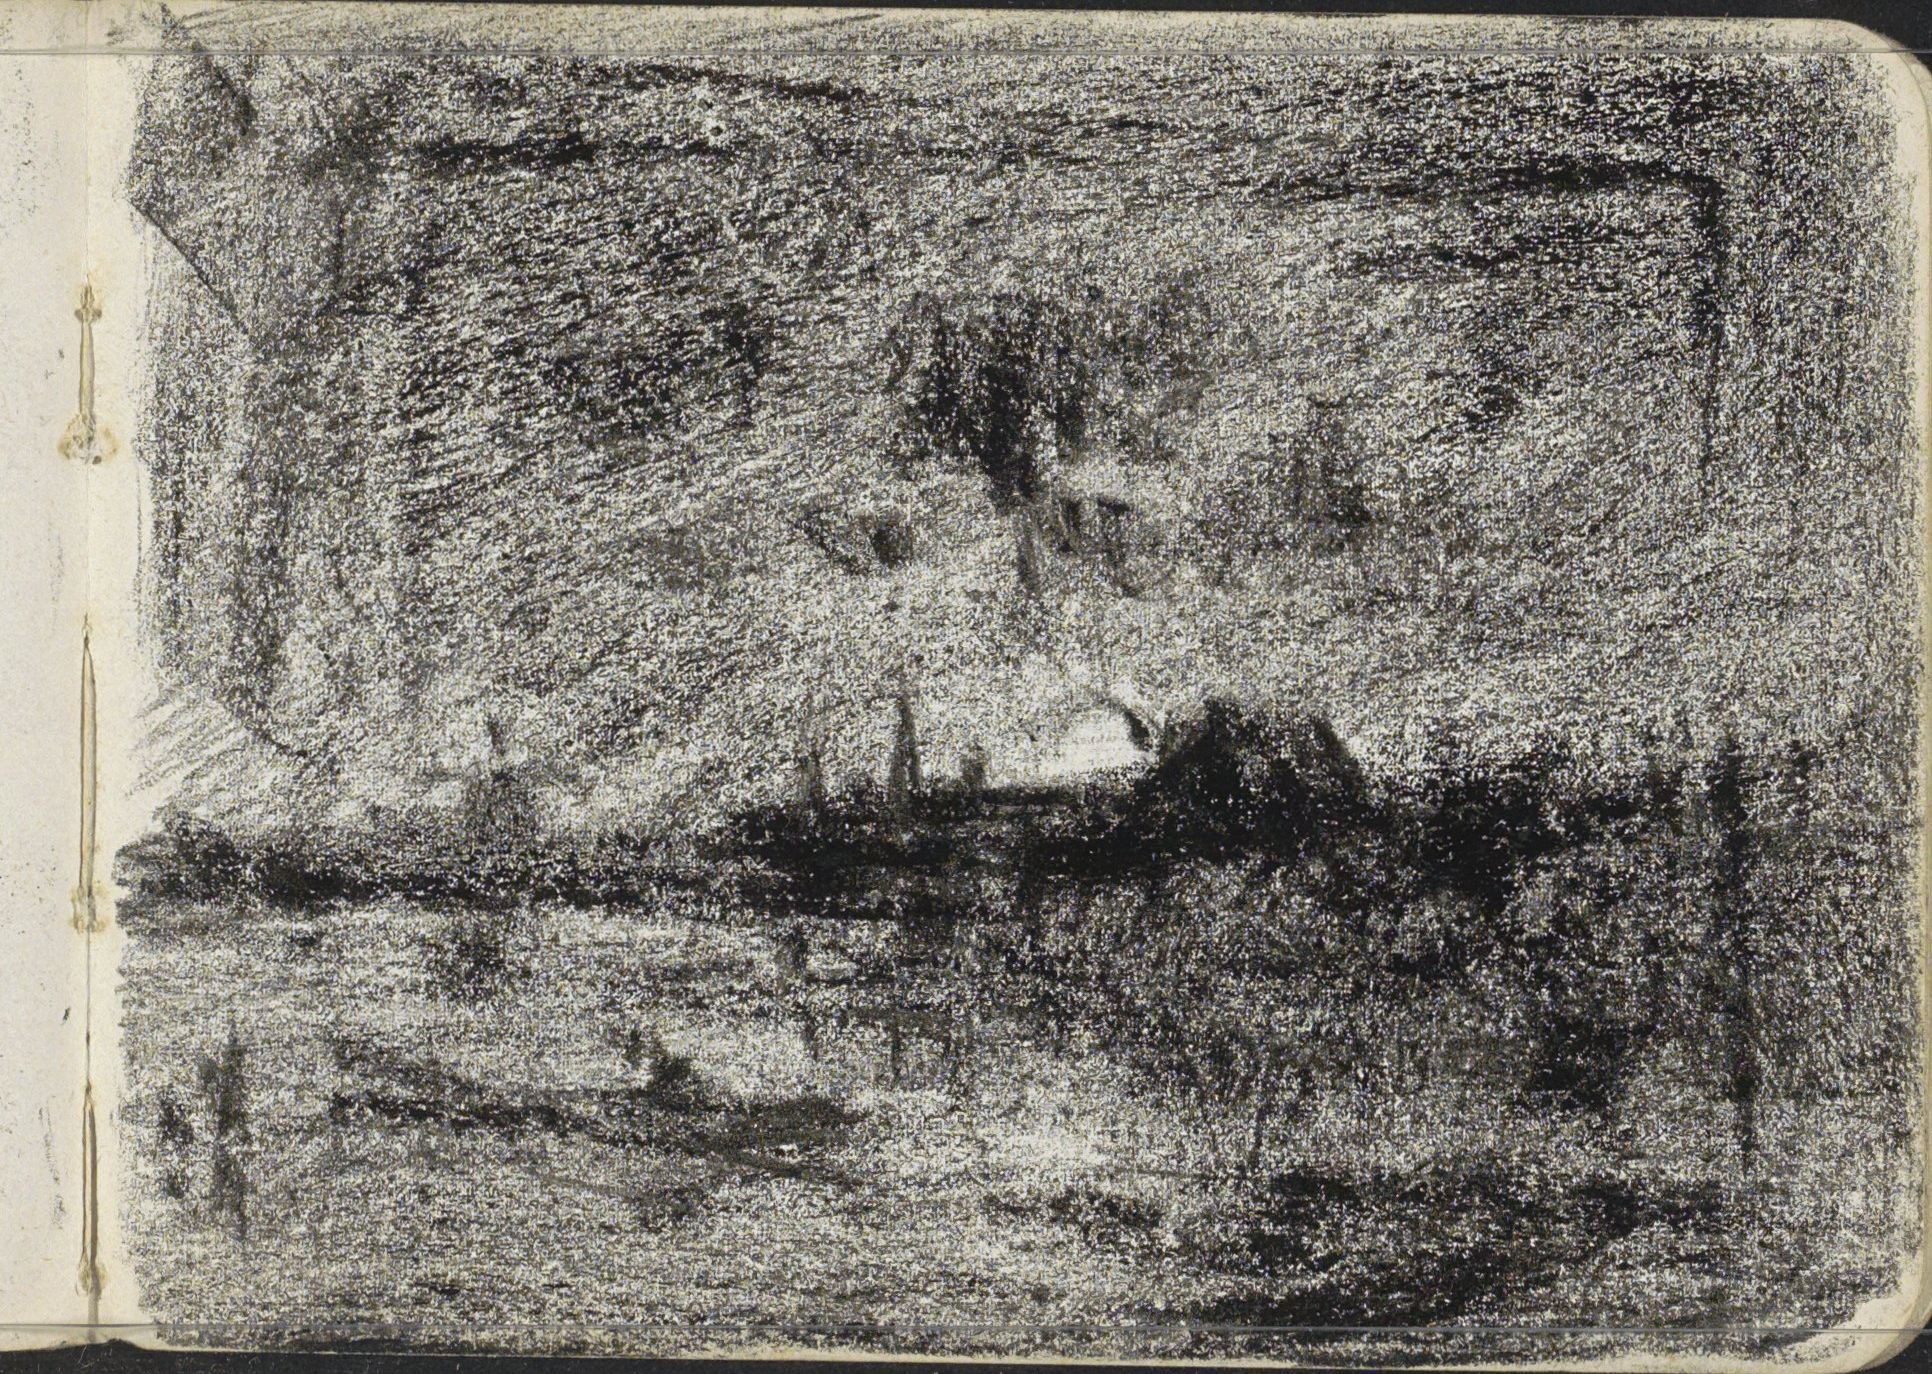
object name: sketchbook leaf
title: Rivierlandschap met molens en huizen aan een waterkant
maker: willem cornelis rip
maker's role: draughtsman, painter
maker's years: 1856-1922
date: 1907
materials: chalk, paper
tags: river, village, windmill in landscape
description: Blad 37 recto uit een schetsboek met 41 bladen.